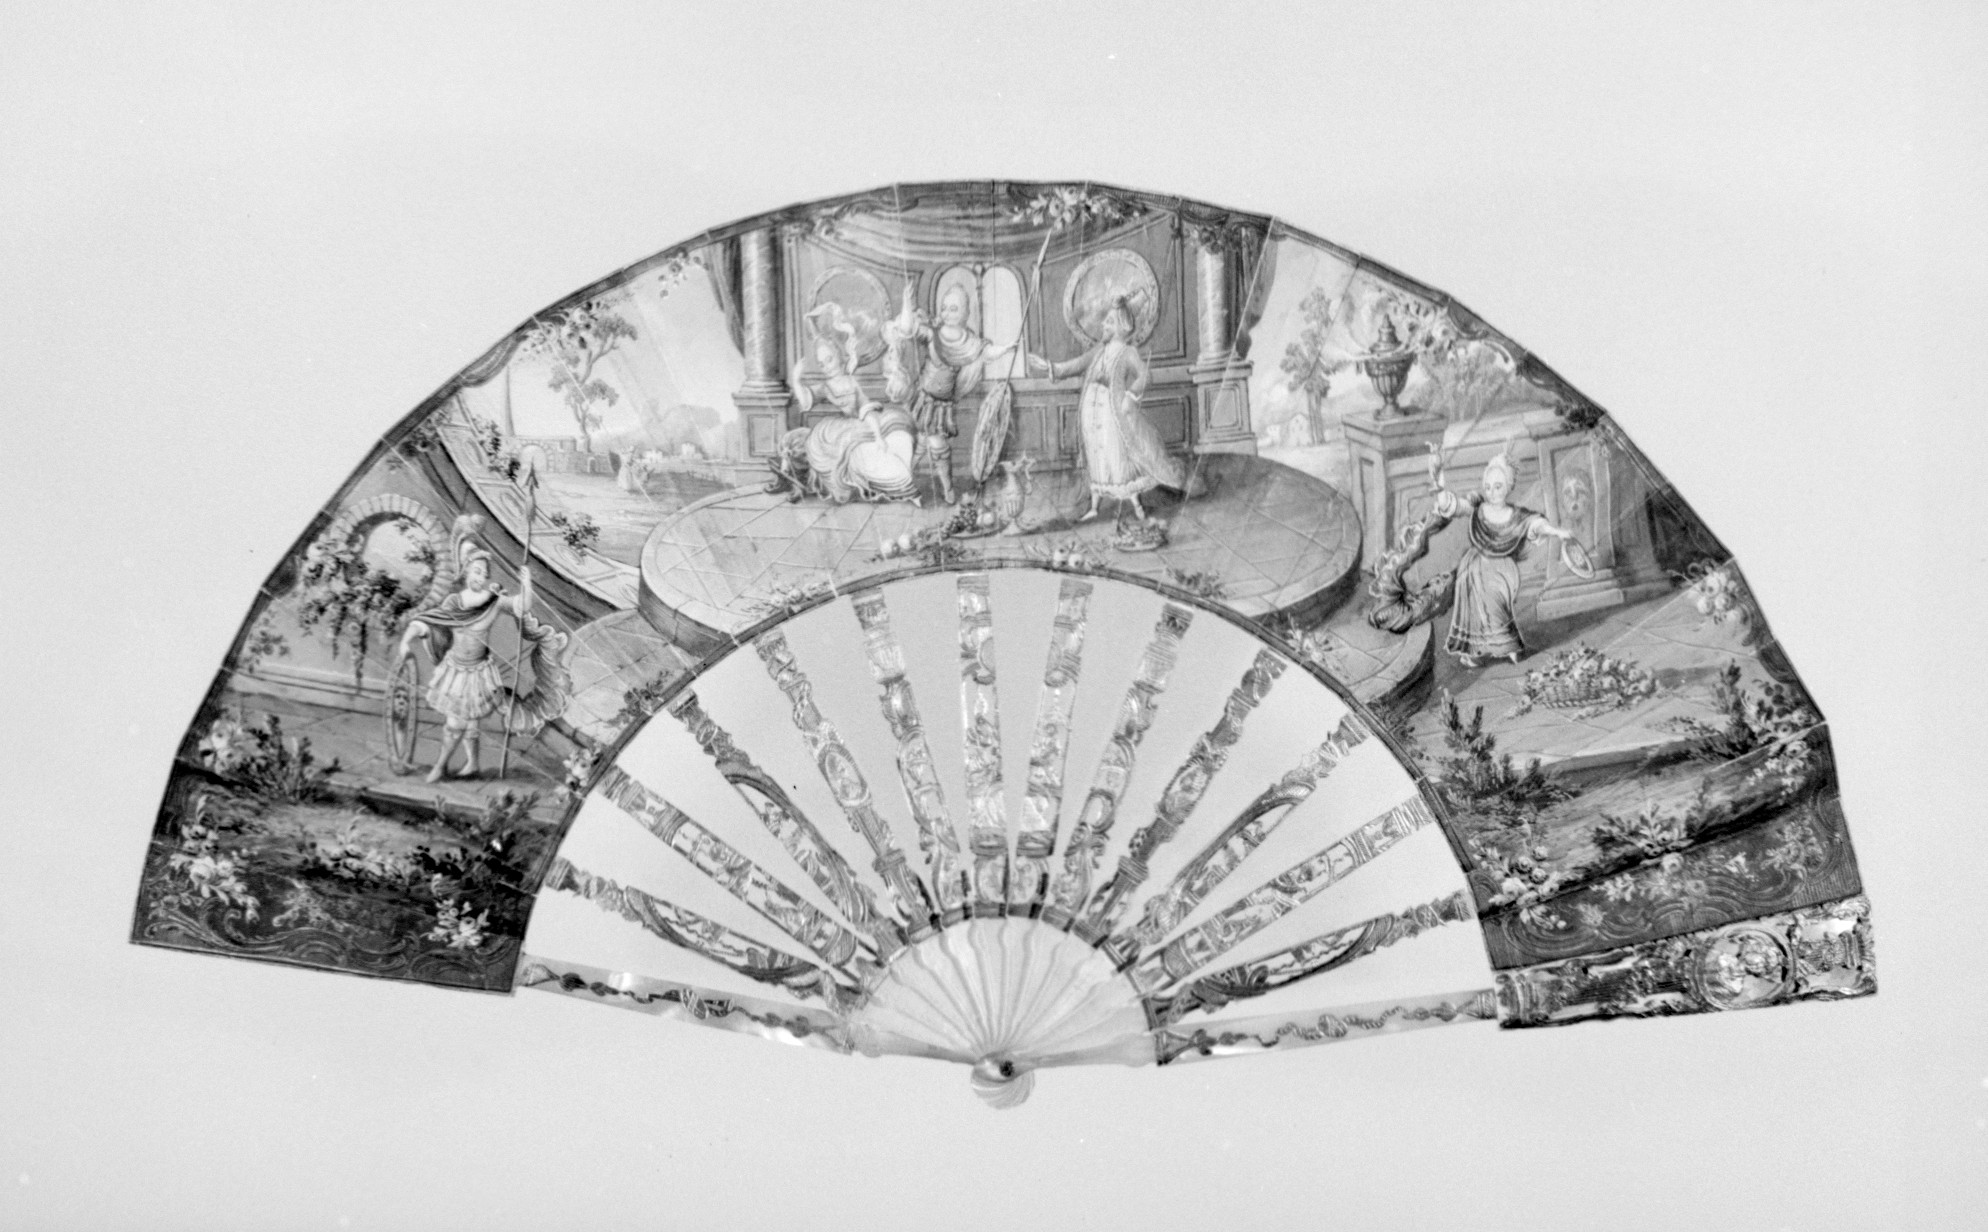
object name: fan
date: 1701-1800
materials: mother of pearl, paper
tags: men,women